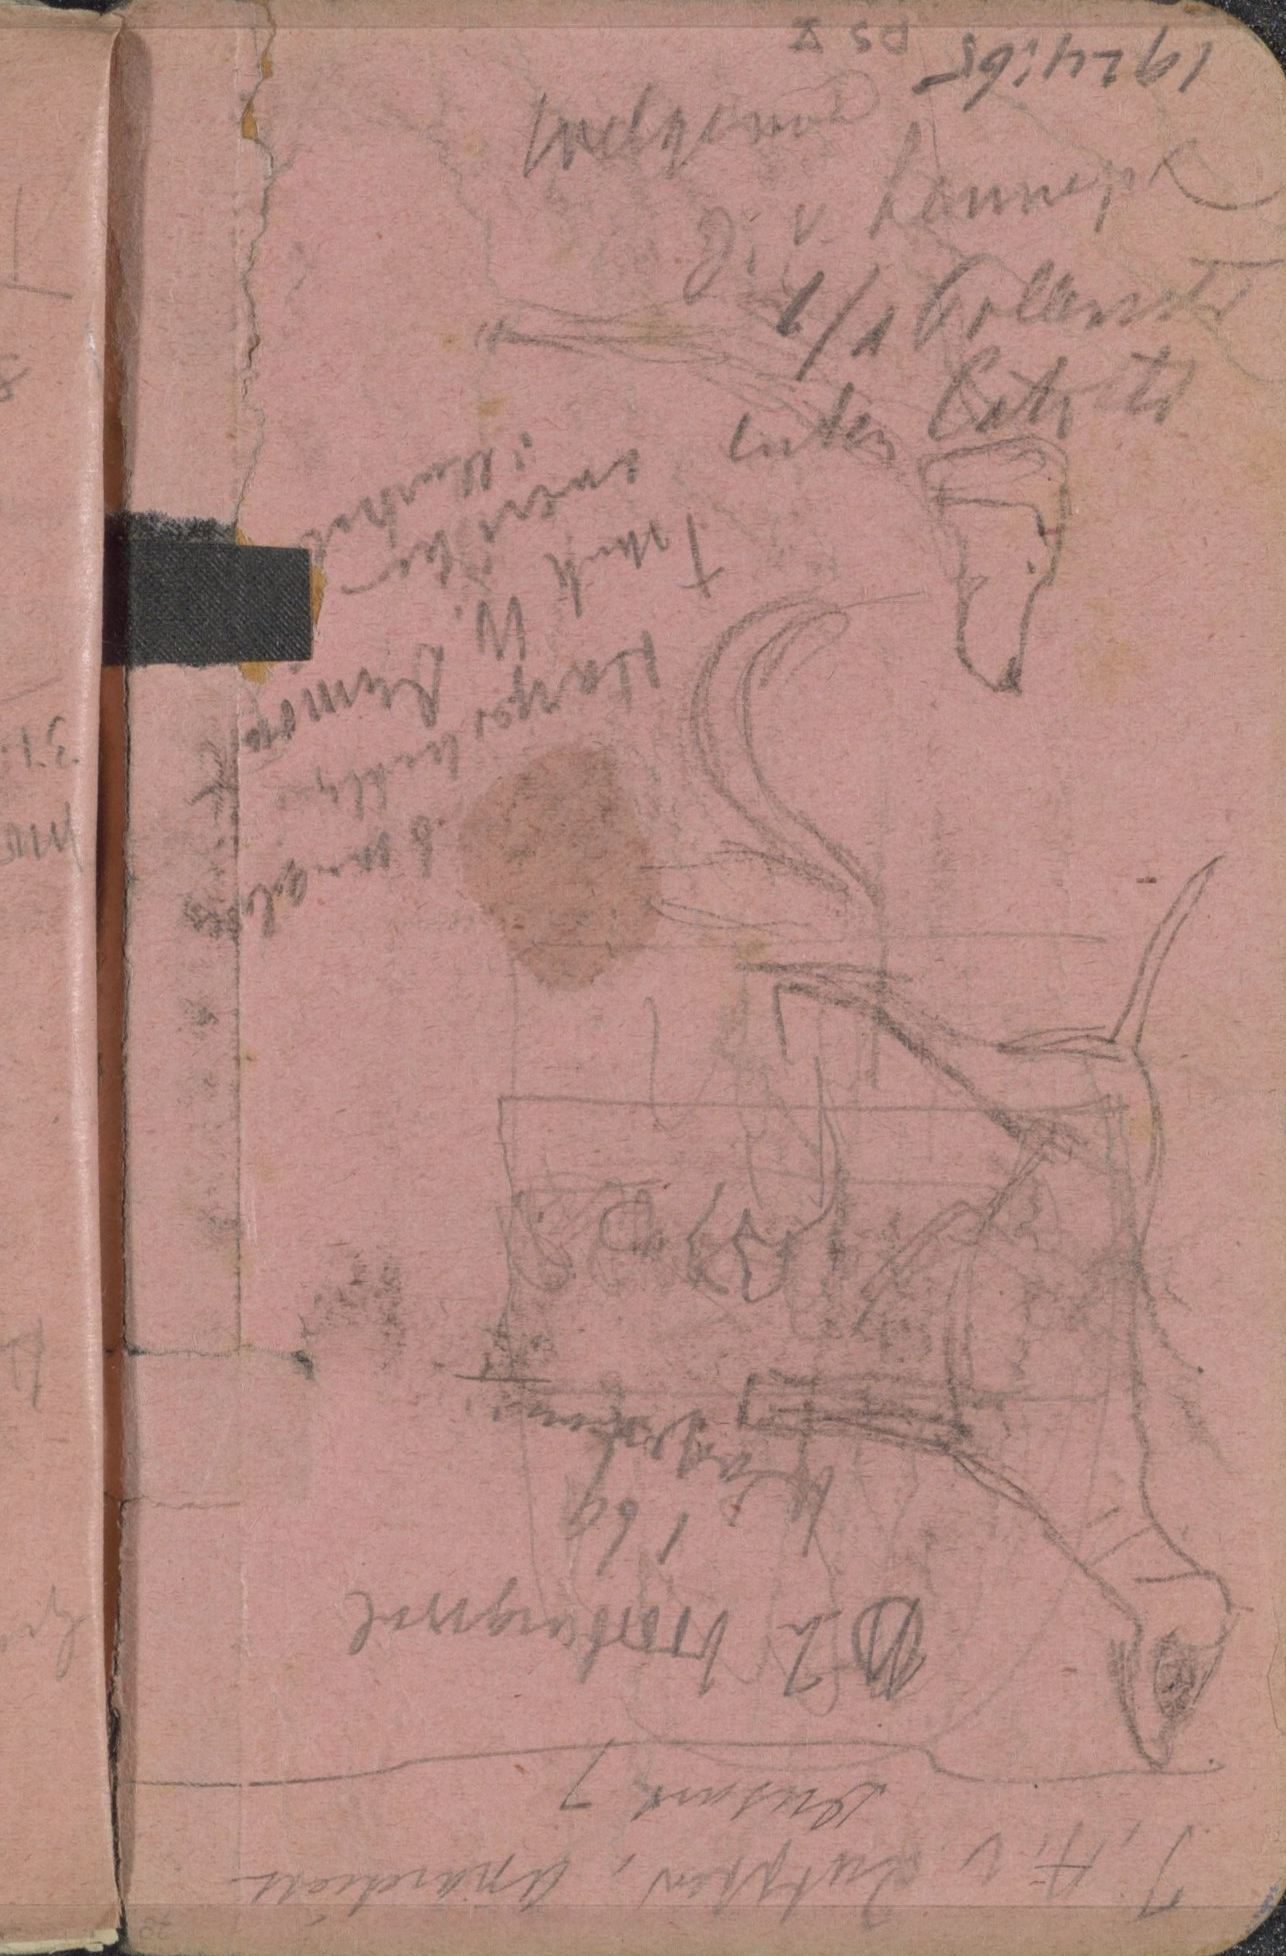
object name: endleaf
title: Studieblad met honden en annotaties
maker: george hendrik breitner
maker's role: draughtsman, painter, print maker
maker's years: 1857-1923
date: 1896-1897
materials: chalk, paper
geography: amsterdam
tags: dog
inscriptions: annotation: ‘J.A. v Zutphen, [...]/ Dusart 7/ O.Z Voorburgwal/ 169/ [...]/ J. v. Lennep[...]/ b/d Tollensstr/ [...]’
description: Pagina 80, achterste schutblad, uit een schetsboek met 39 bladen.